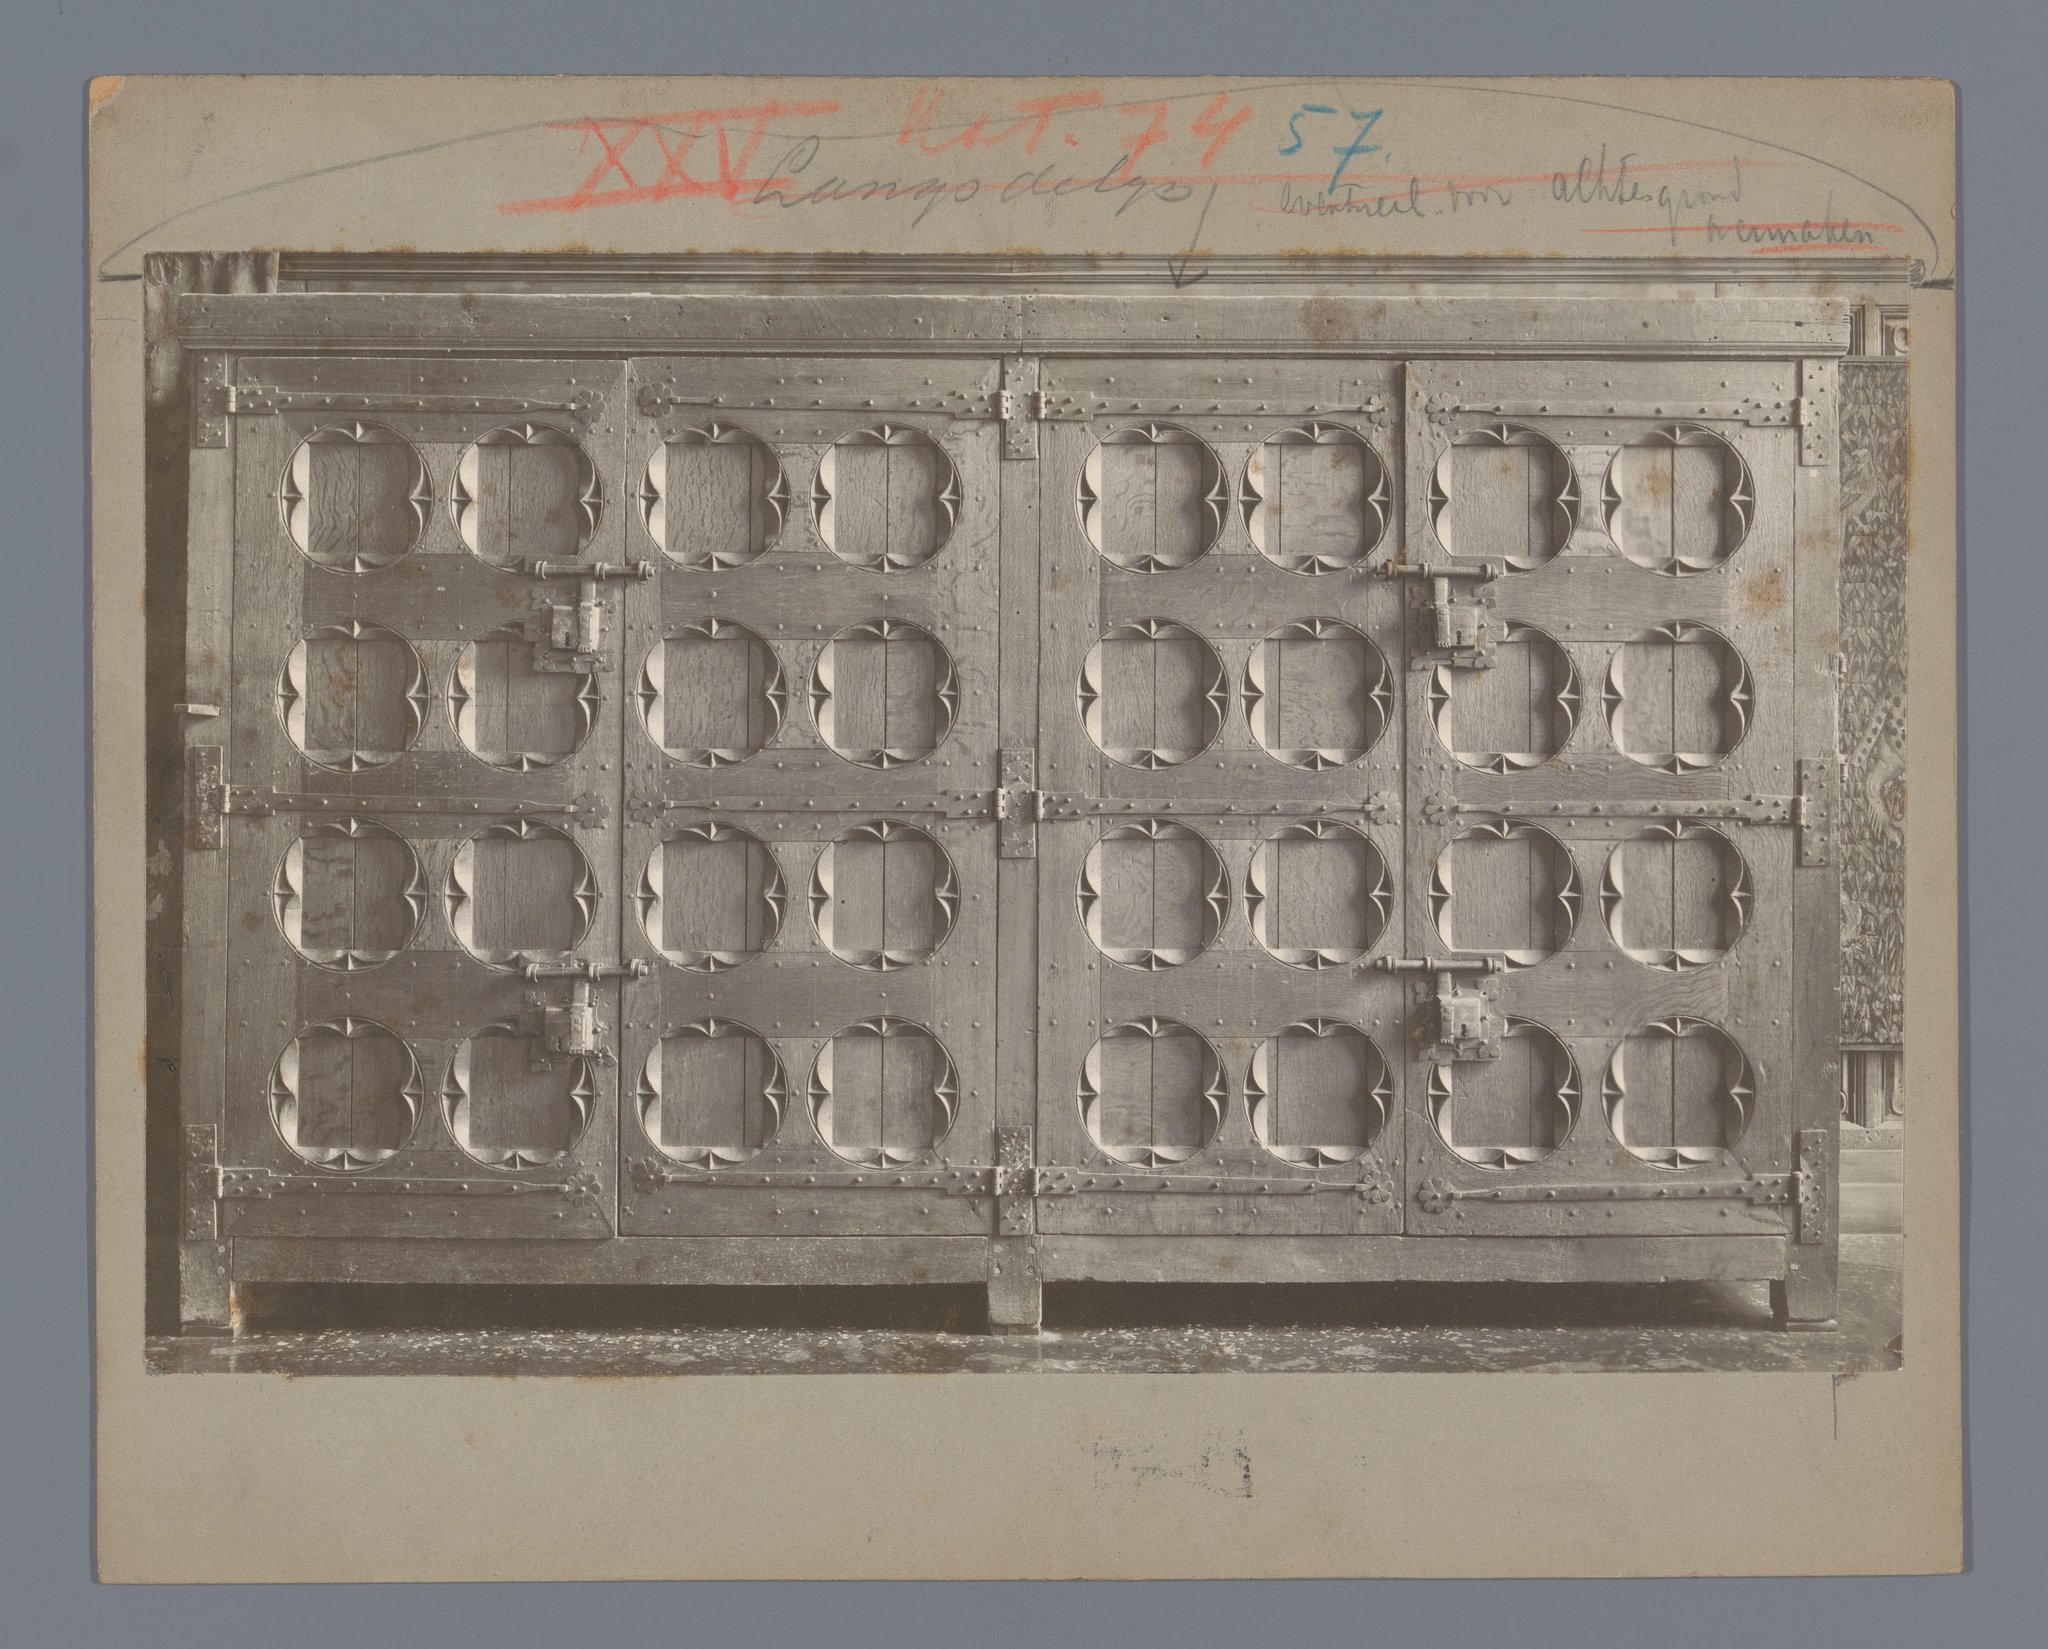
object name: photograph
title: Archiefkast van het domkapittel van Utrecht in het Rijksmuseum te Amsterdam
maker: Anonymous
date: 1875-1900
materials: paper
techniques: carbon print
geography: amsterdam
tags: chest, coffer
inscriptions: collector's mark: ‘Instituut voor kunst-nijverheidsonderwijs Gabriël Metsustraat No. 16, Amsterdam’, collector's mark: ‘Kunstnijverheidschool Quellinus Amsterdam Frans Halsstraat 14.’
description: Zie voor het originele object BK-NM-125.